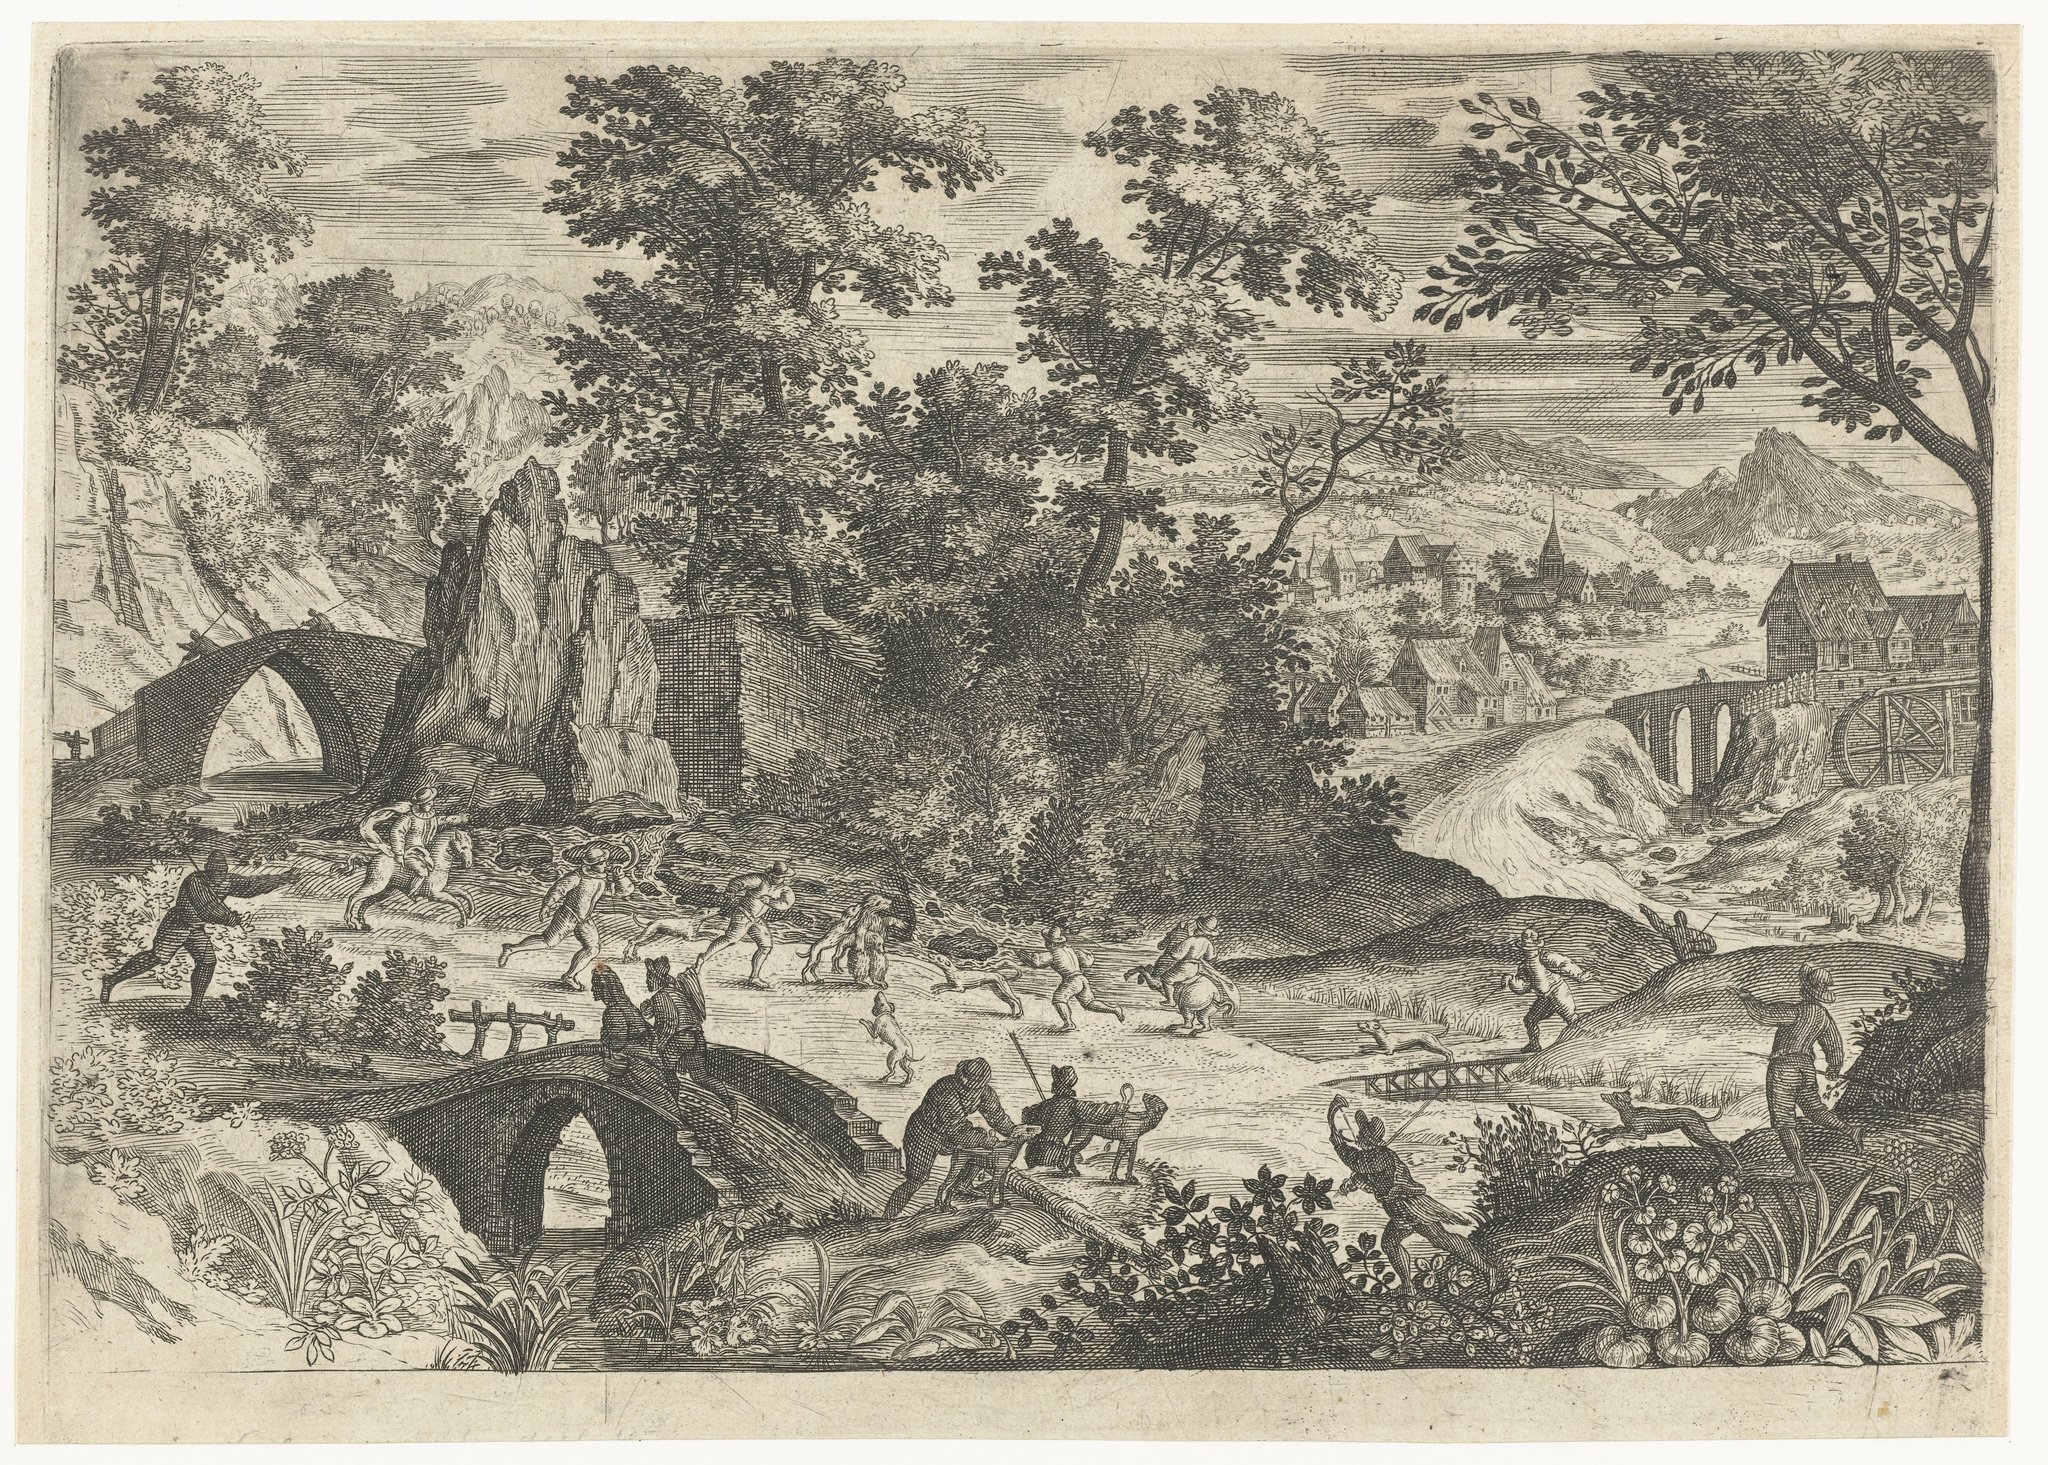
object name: print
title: Landschap met berenjacht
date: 1575-1603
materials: paper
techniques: etching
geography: low countries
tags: landscapes in the temperate zone, hunt ~ predatory animals (fox, lion), sports, games ~ animals (+ hunting with dogs)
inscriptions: collector's mark: Lugt 2228a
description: In een bergachtig landschap jaagt een groep mannen met hun honden op een beer. Op de achtergrond rechts een dorp.